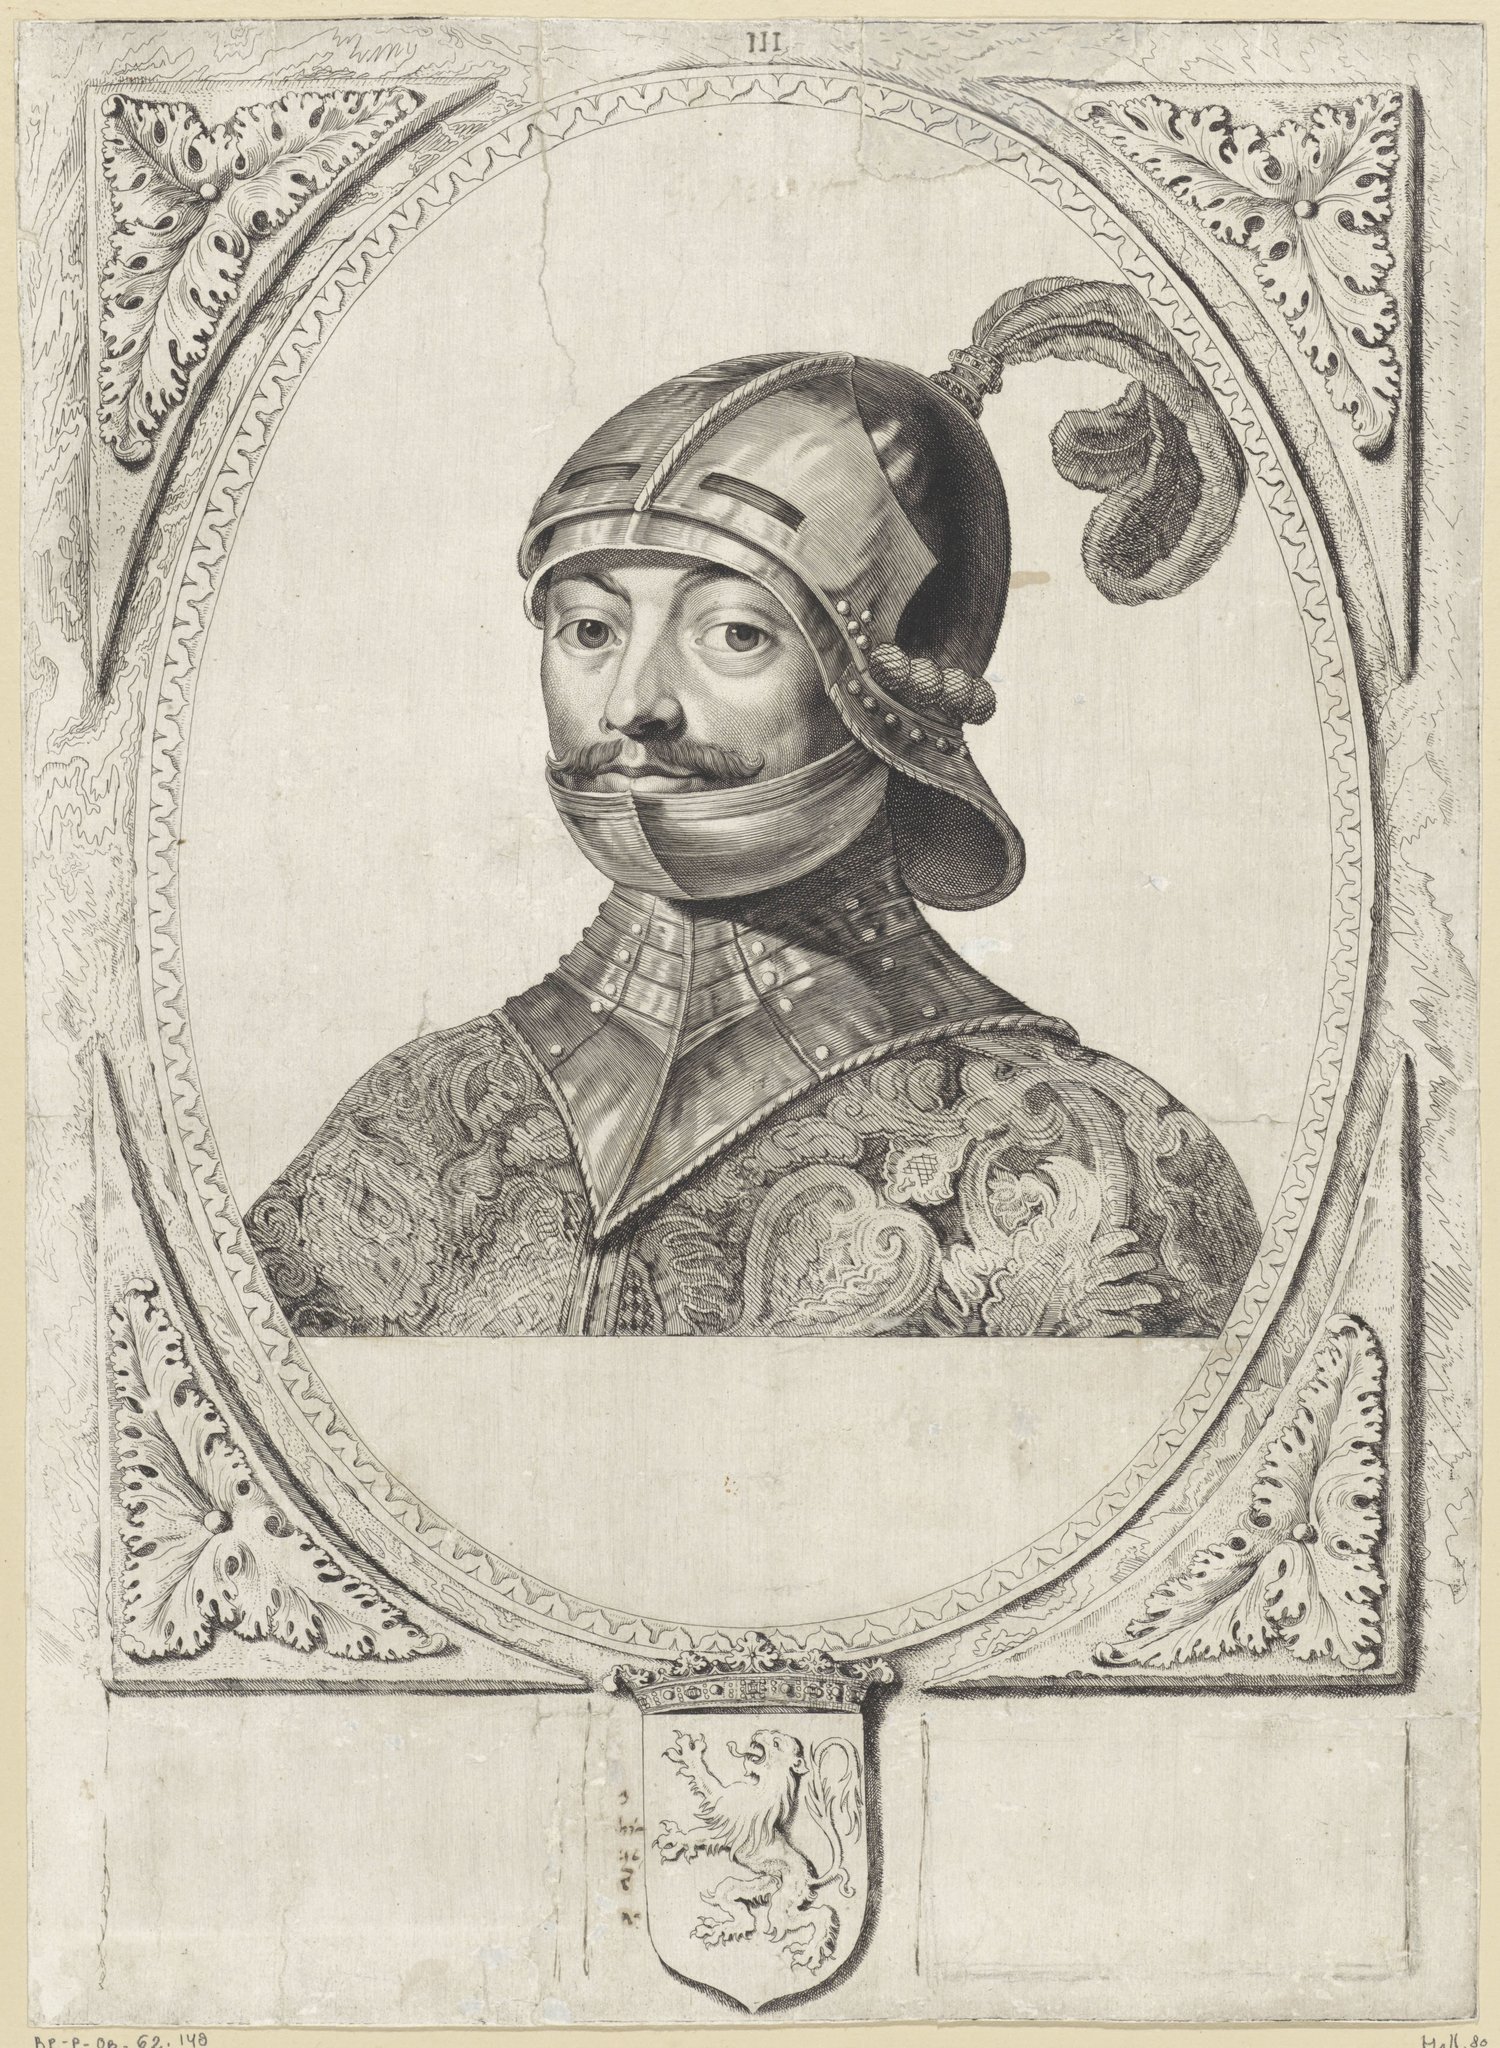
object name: print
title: Portret van Arnulf, graaf van Holland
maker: cornelis visscher (ii)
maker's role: draughtsman, painter, print maker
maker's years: 1628-1658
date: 1650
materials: paper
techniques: engraving, etching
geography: haarlem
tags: earl, helmet, armour, nobility and patriciate; chivalry, knighthood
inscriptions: collector's mark: Lugt 240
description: Proefdruk van de derde prent uit de serie 'Graven en gravinnen van Holland, Zeeland en West-Friesland', bestaande uit 38 prenten.